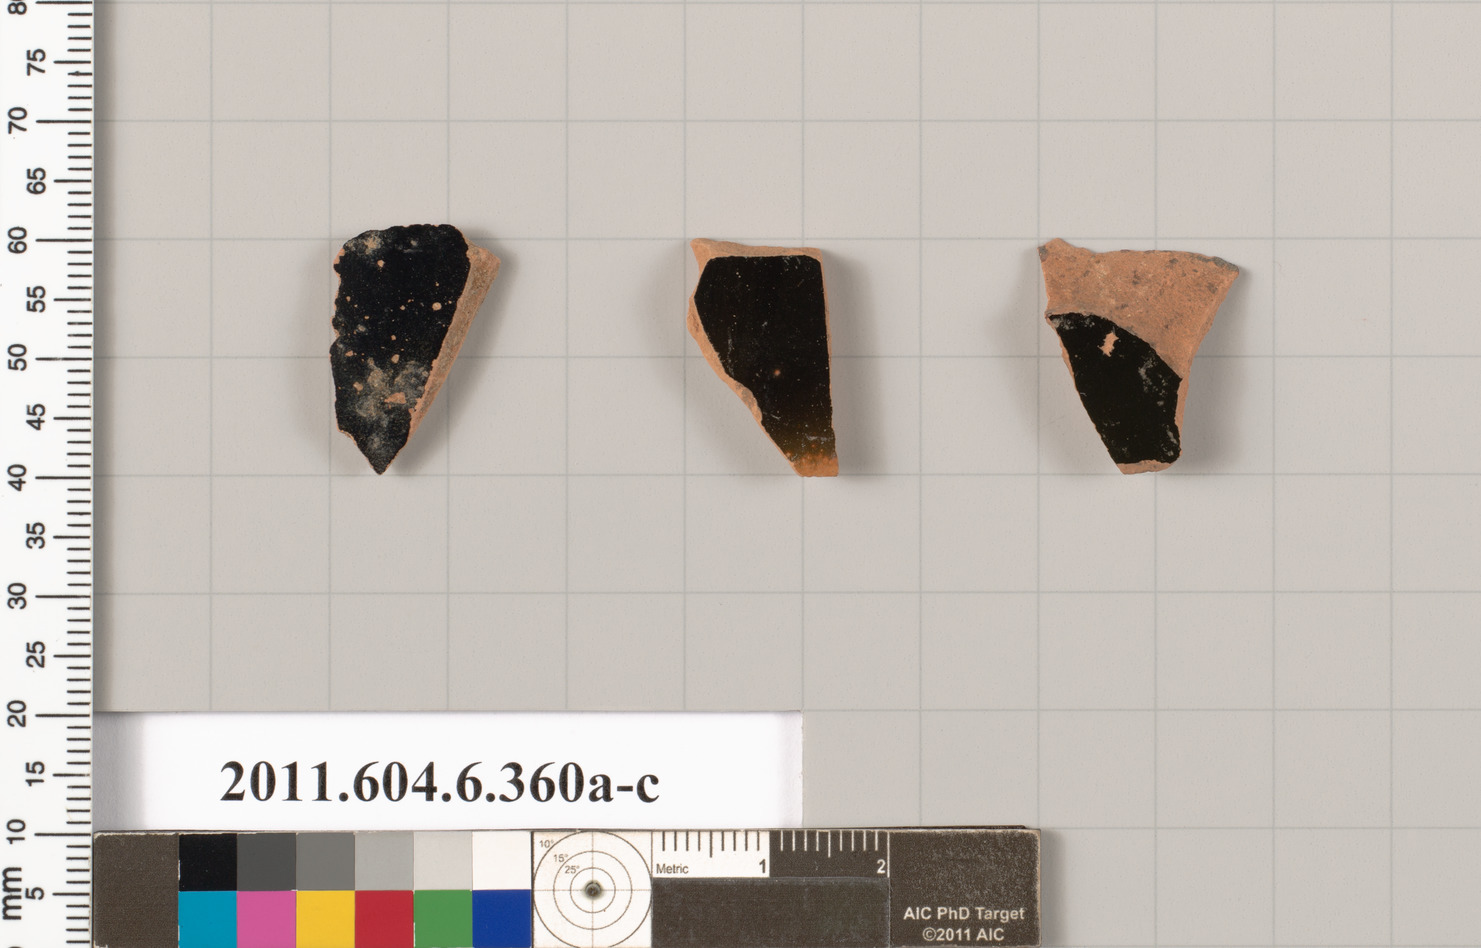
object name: undetermined closed shape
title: Terracotta fragments of closed shapes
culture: greek, attic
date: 600-401 BCE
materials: terracotta